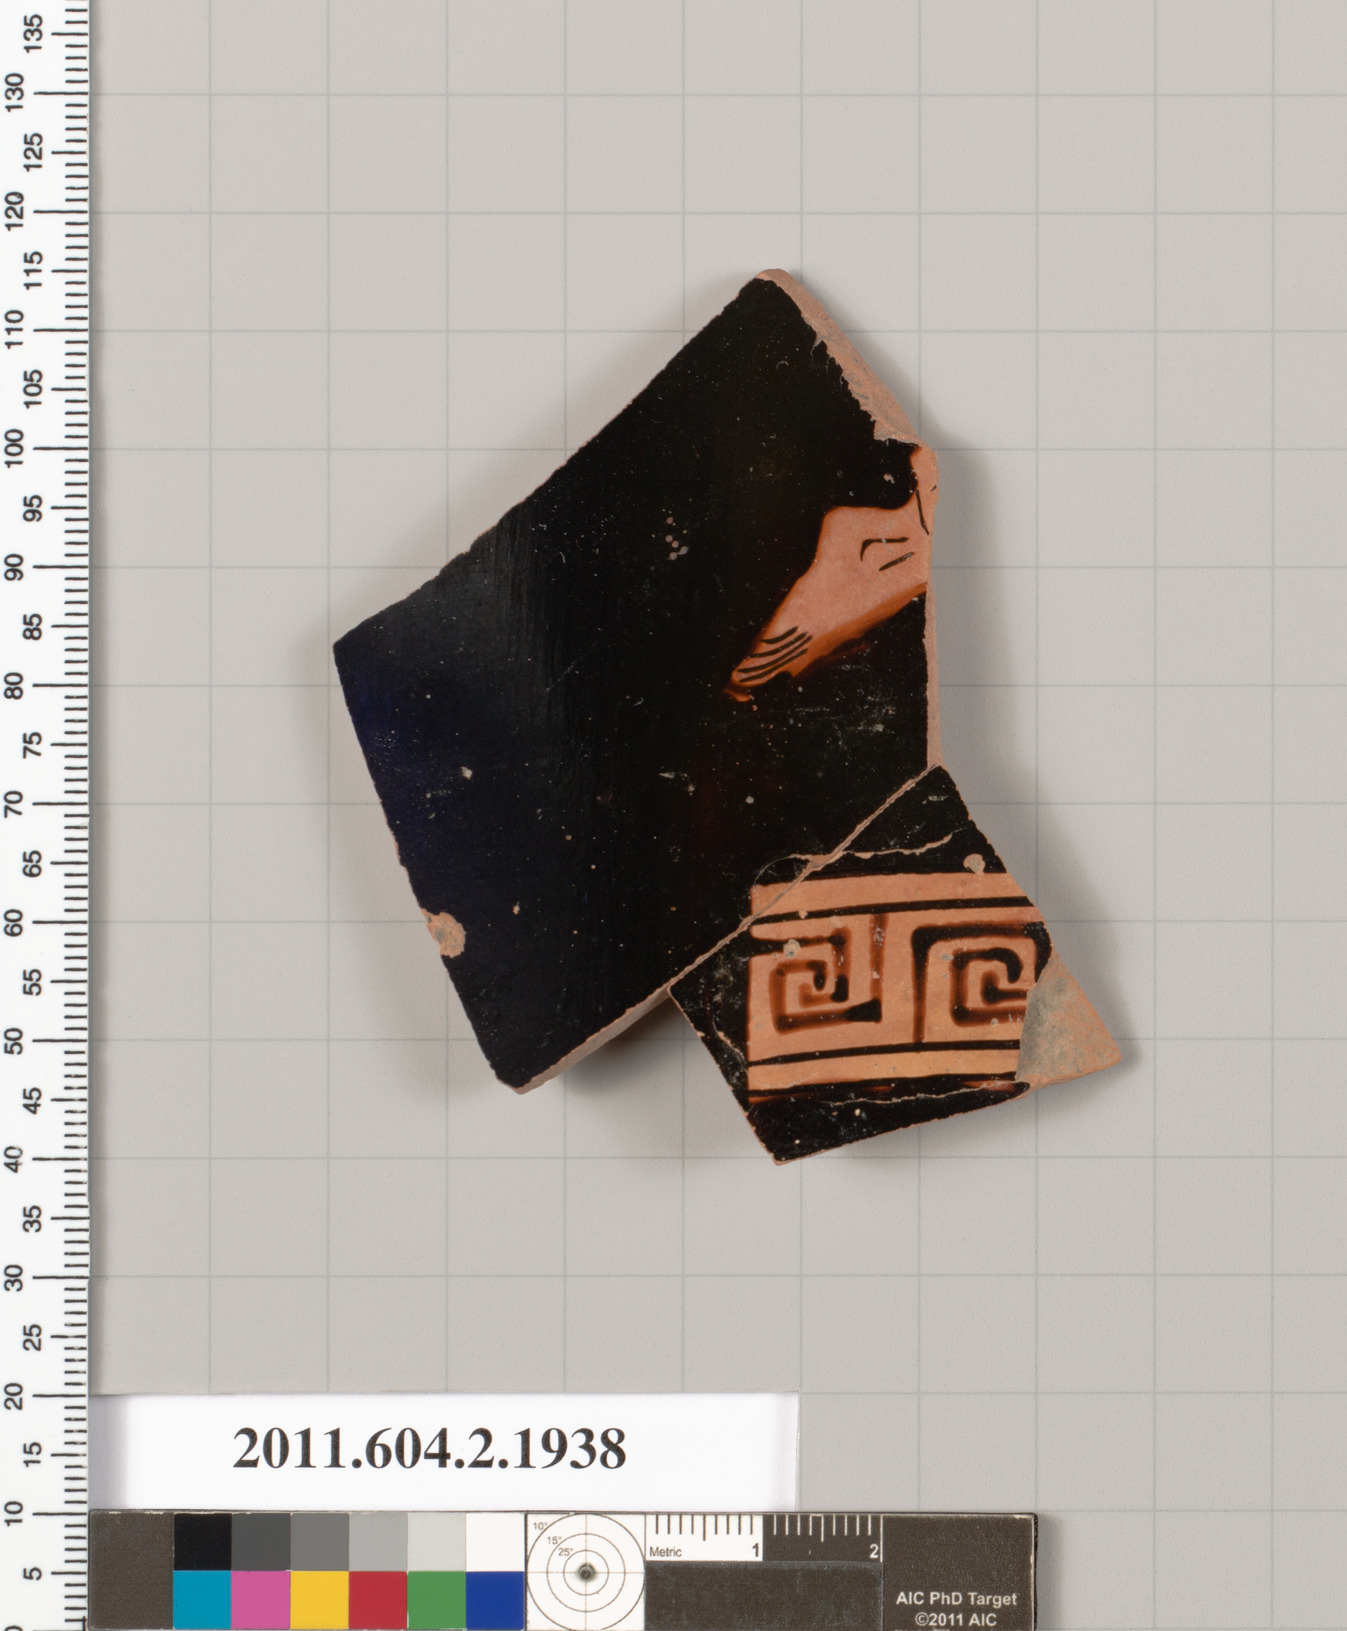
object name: neck amphora fragment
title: Terracotta fragment of a Nolan neck-amphora (jar)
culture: greek, attic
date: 475-460 BCE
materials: terracotta